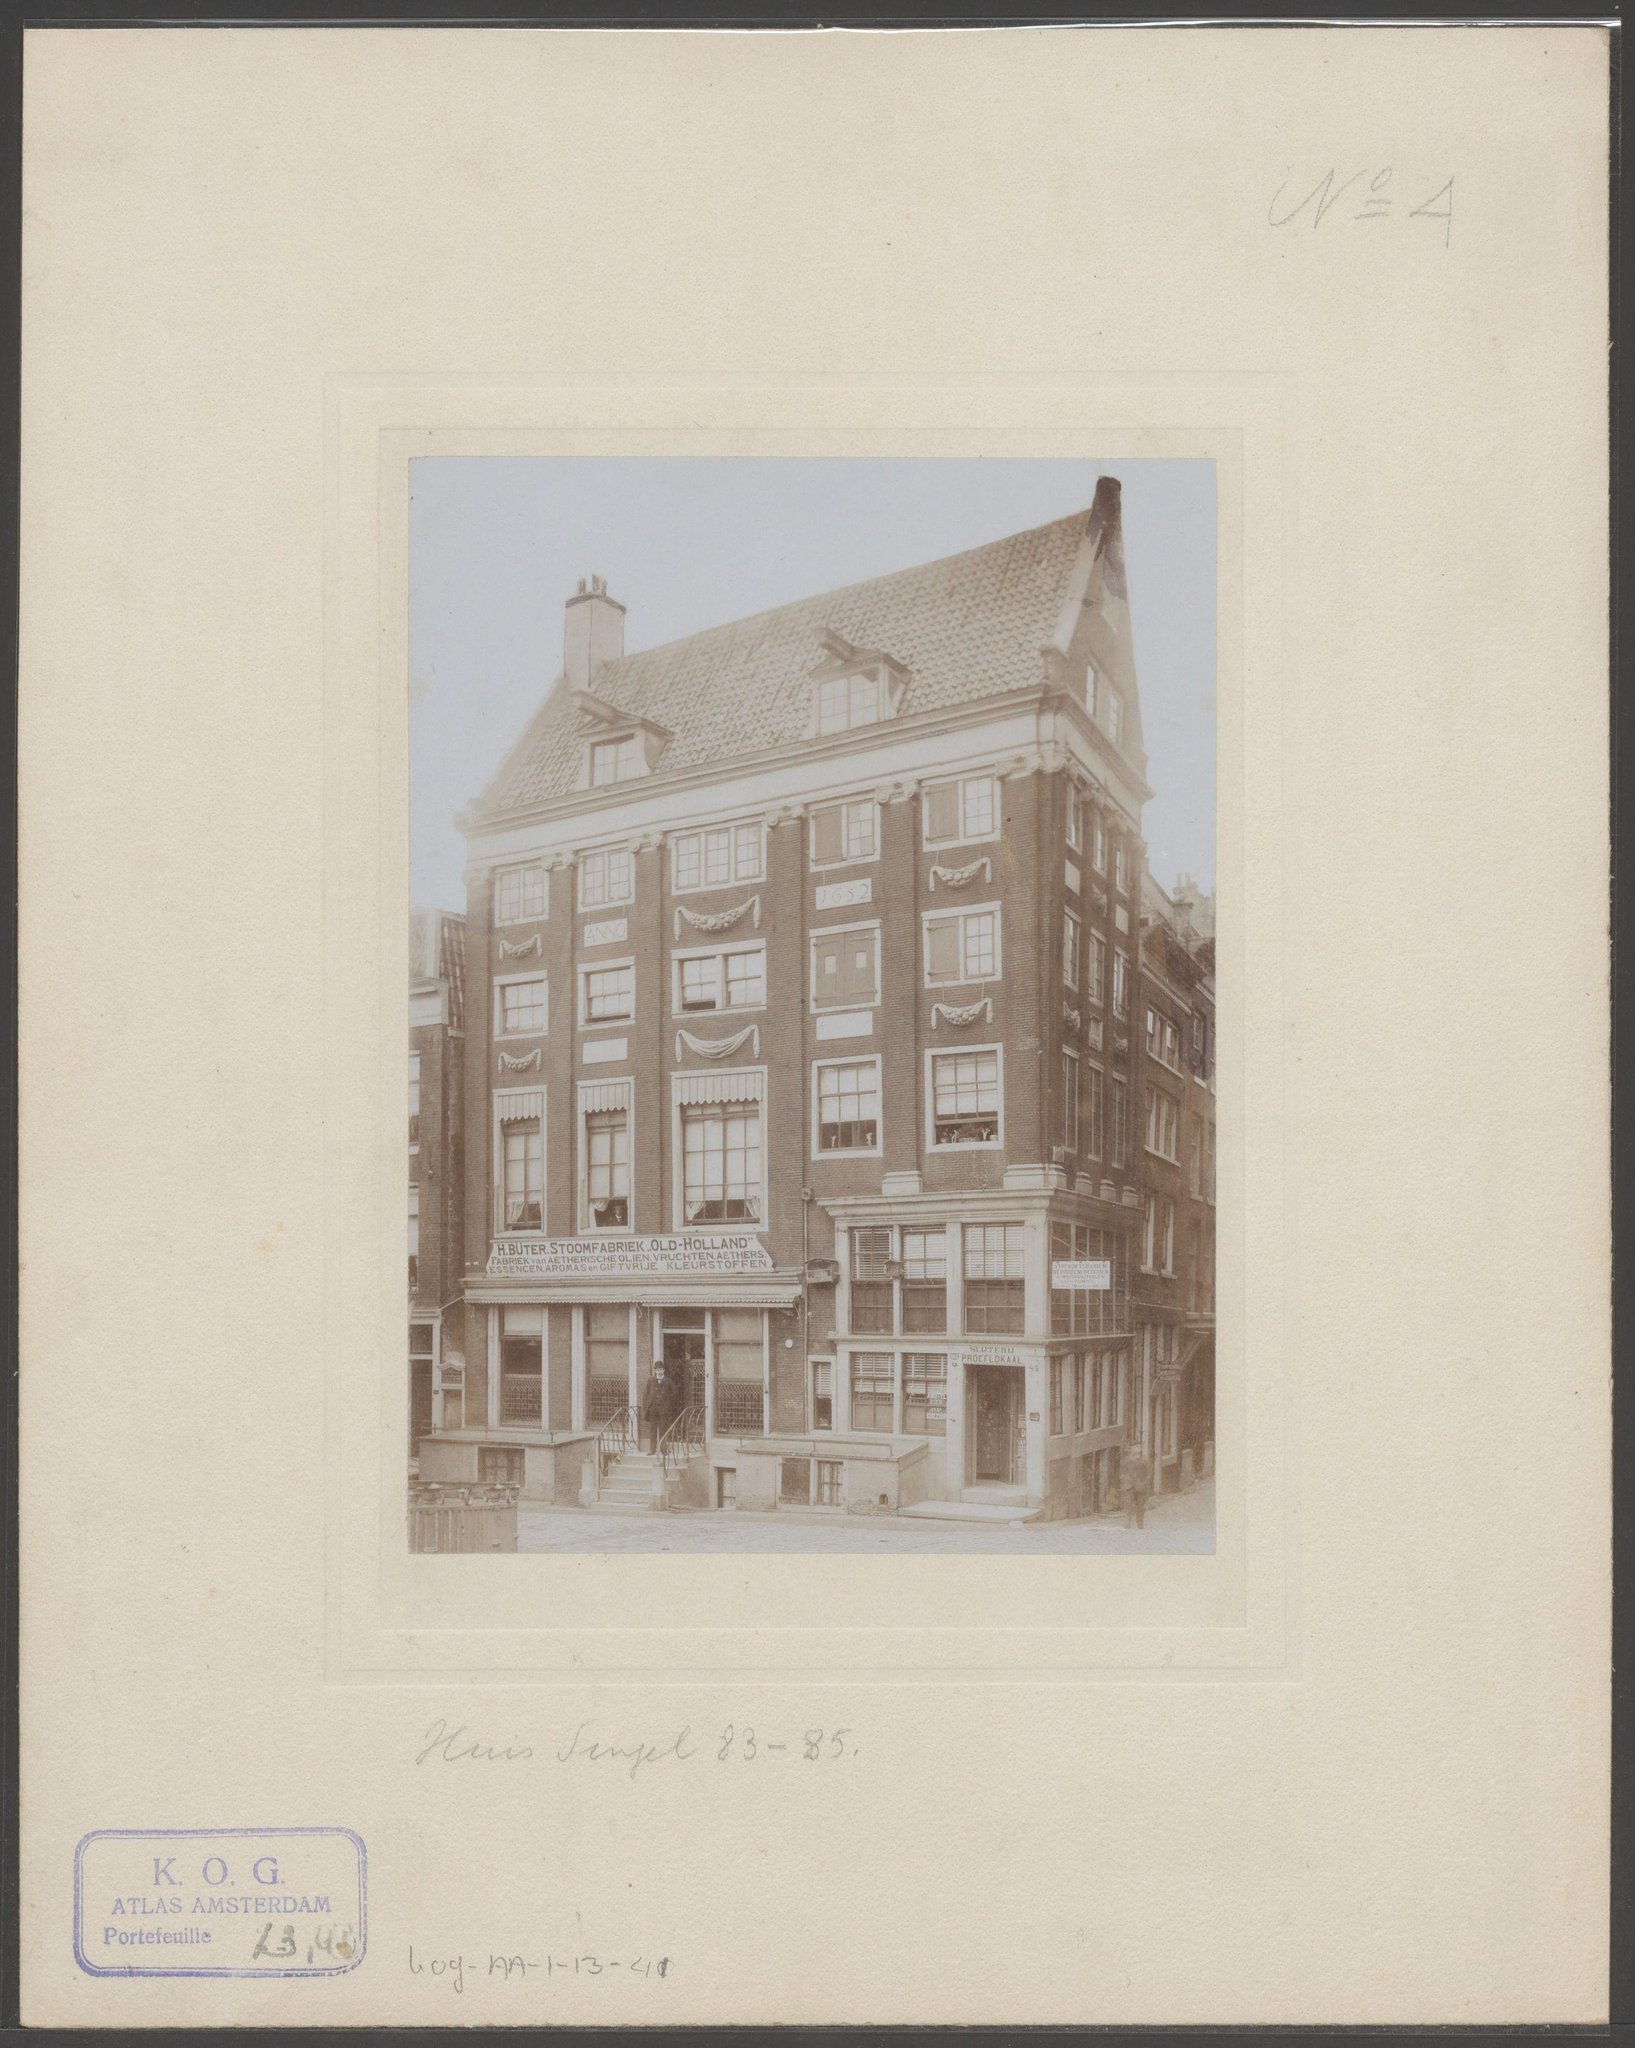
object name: photograph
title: Gezicht op Singel 83-85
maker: Anonymous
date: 1865-1940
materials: paper, cardboard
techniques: collodion silver print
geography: amsterdam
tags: city-view in general; 'veduta', façade (of house or building), street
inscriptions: inscription: ‘Huis Singel 83-85.’, collector's mark: ‘13,41’ Lugt 1641b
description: Onderwerpsrubriek binnen de Atlas Amsterdam: Oude Schans, Schoutensteeg, Singel (Korte), Singel.